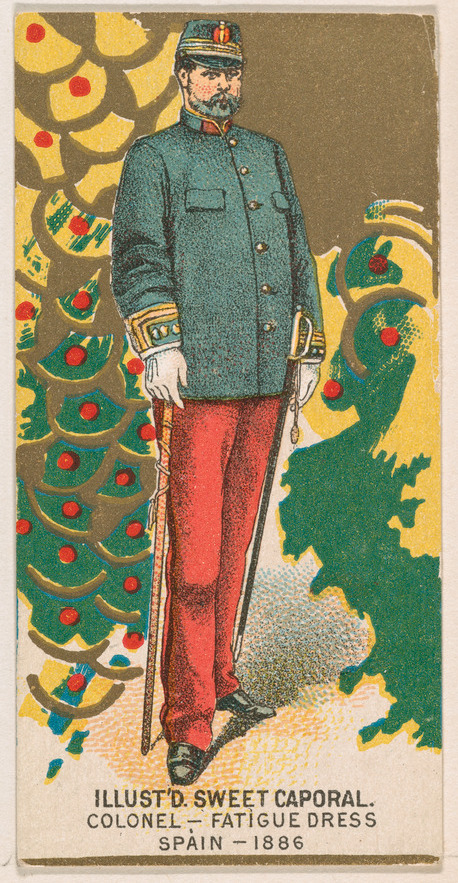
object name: print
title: Fatigue Dress, Colonel, Spain, 1886, from the Military Series (N224) issued by Kinney Tobacco Company to promote Sweet Caporal Cigarettes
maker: kinney brothers tobacco company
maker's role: publisher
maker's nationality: american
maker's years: 1869-2011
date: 1888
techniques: color lithograph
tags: soldiers,men